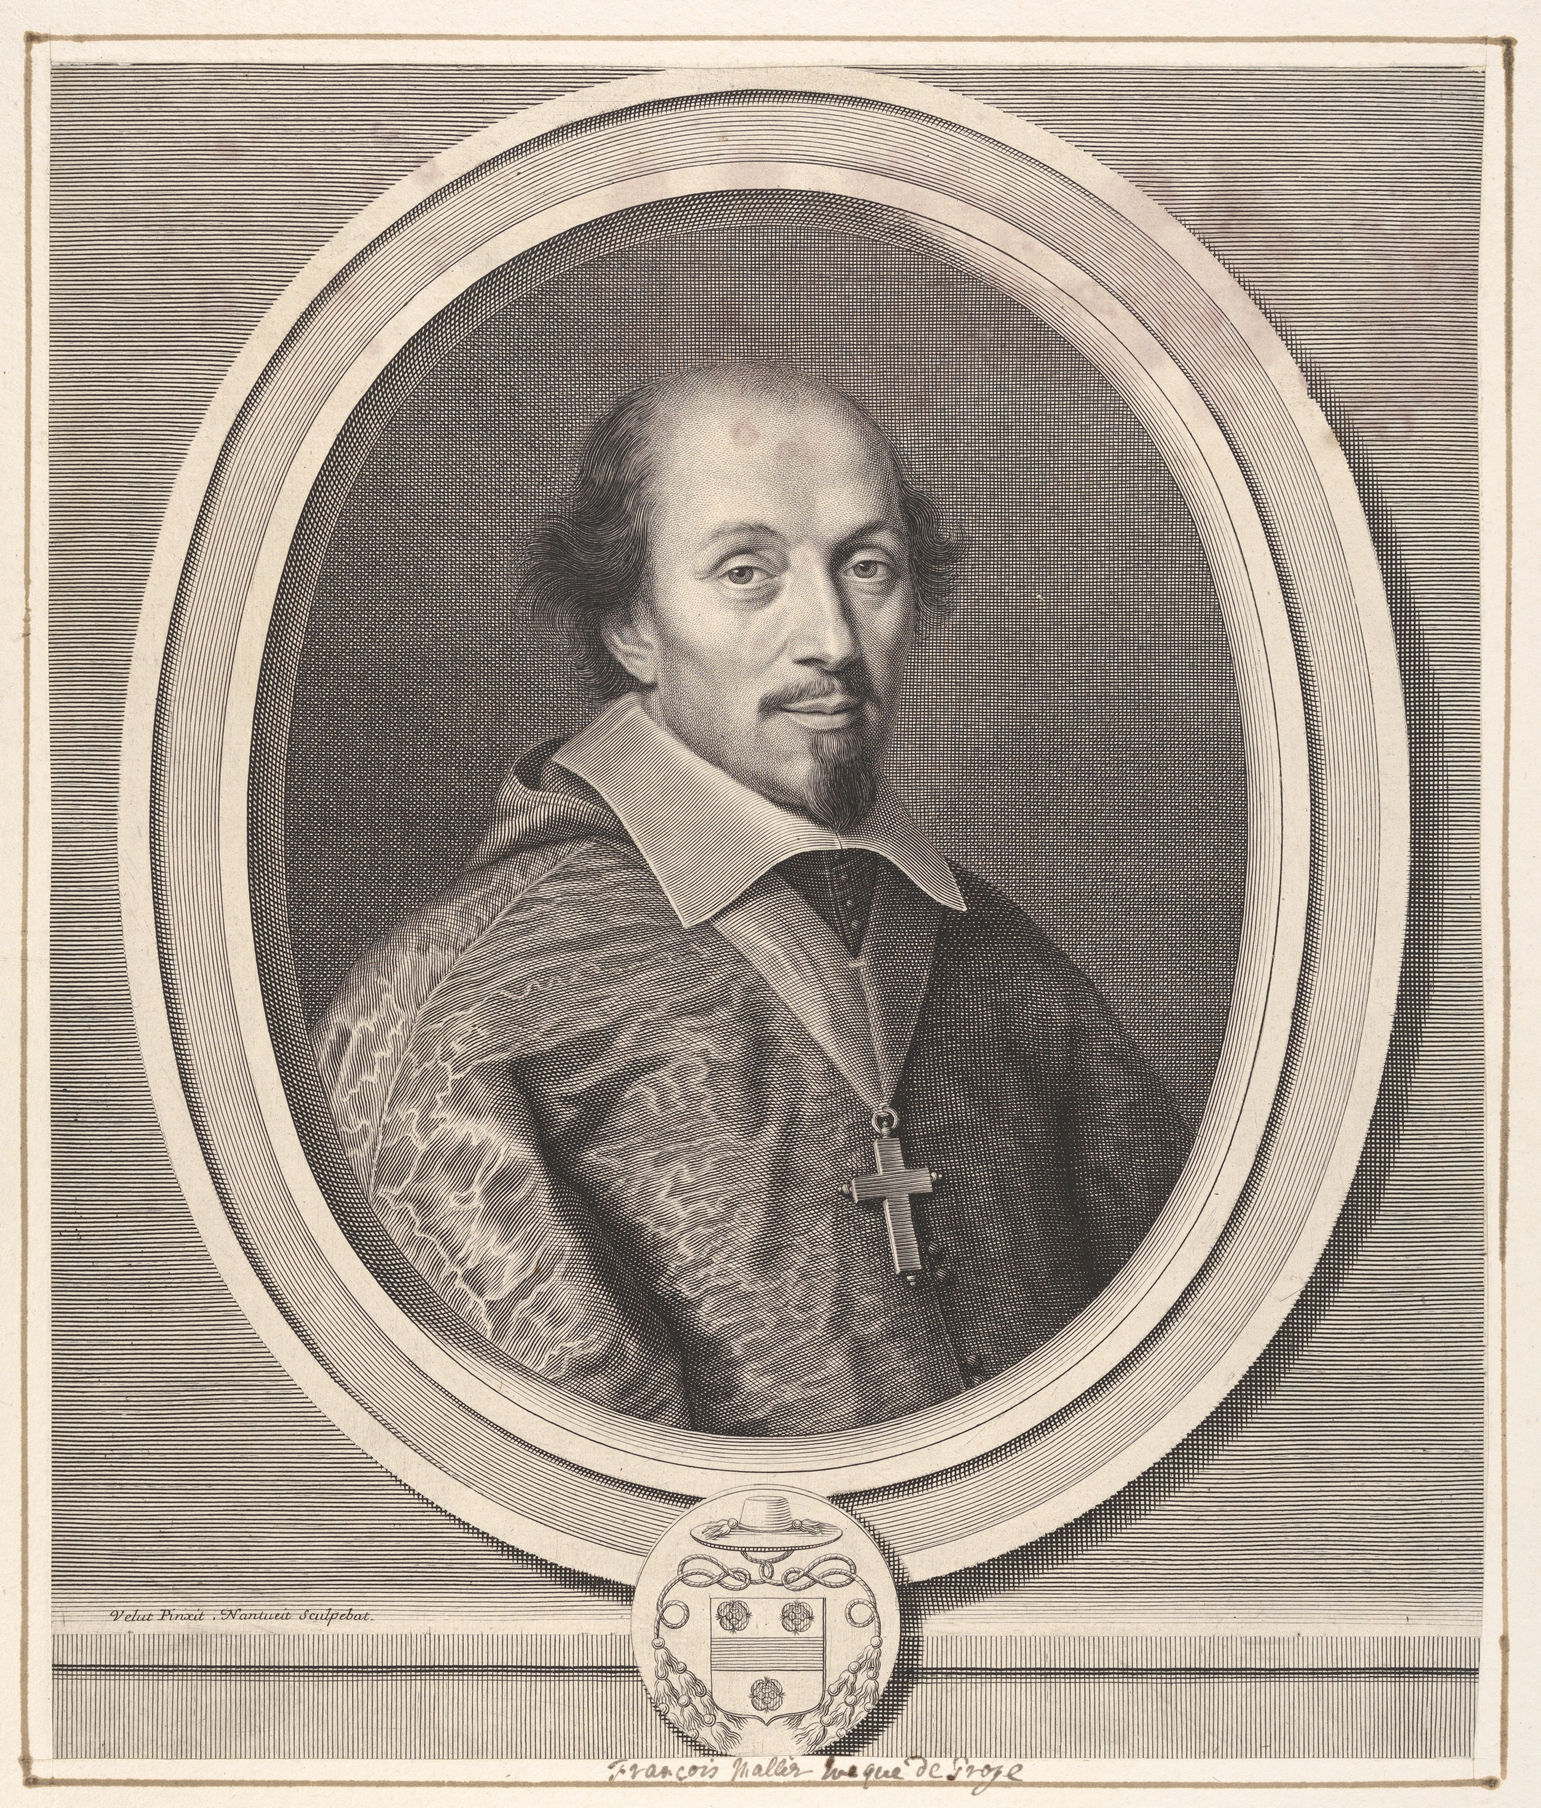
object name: print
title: François Mallier du Houssay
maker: robert nanteuil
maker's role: artist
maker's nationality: french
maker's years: 1623-1678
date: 1656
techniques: engraving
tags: men,portraits,cross